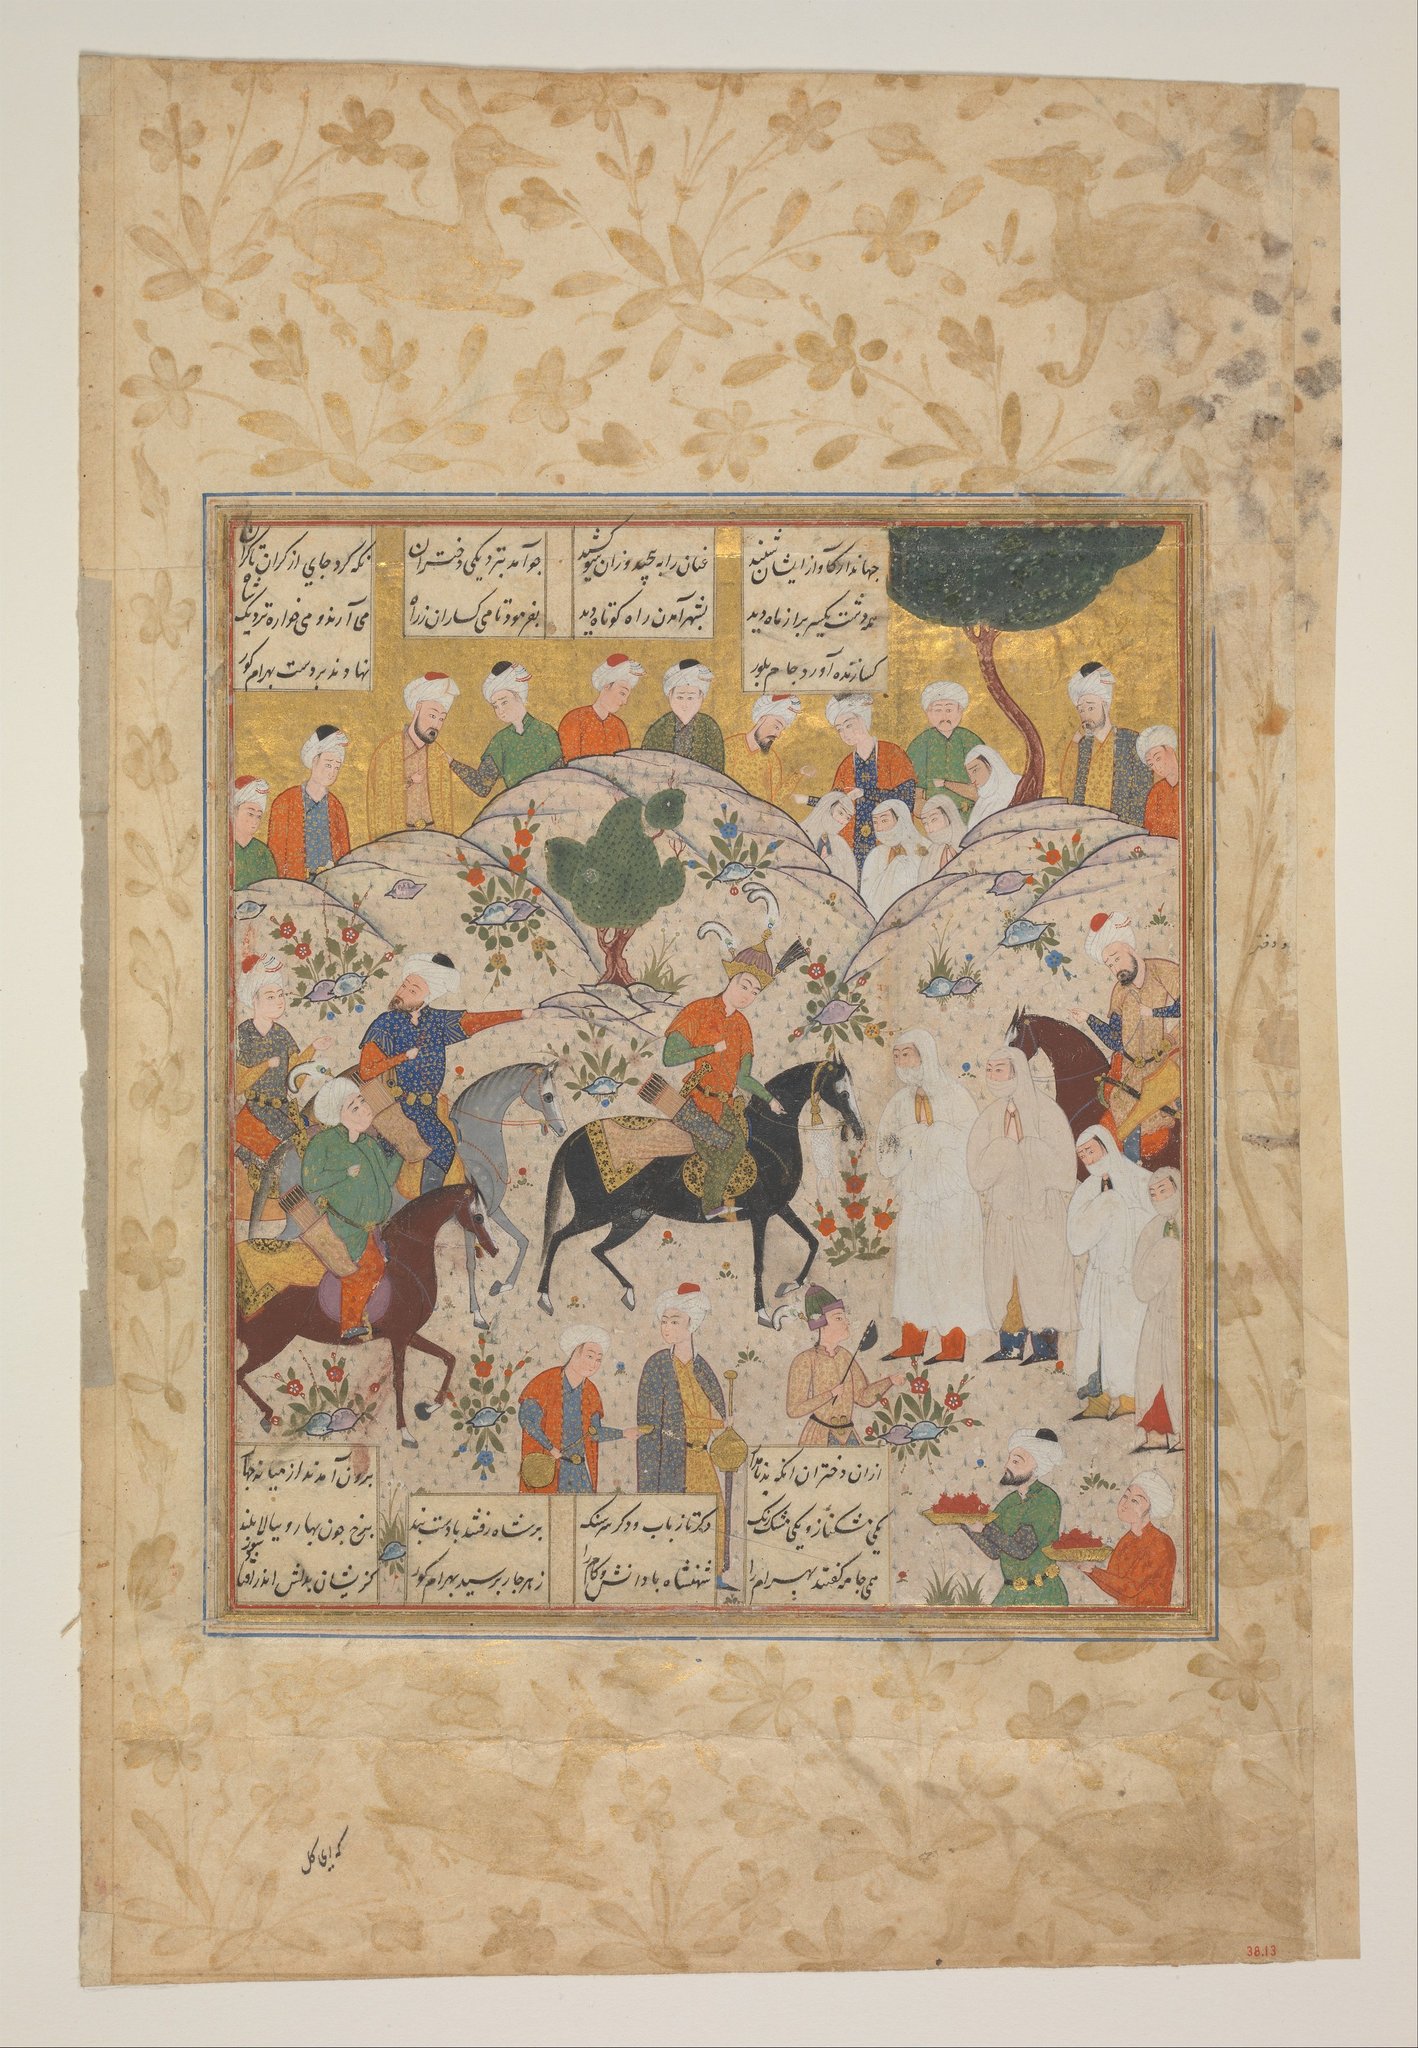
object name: folio from an illustrated manuscript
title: "Meeting of Bahram Gur with a Princess", Folio from a Shahnama (Book of Kings)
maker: abu'l qasim firdausi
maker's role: author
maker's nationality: iranian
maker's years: 935-1020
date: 1534-1566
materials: gold, ink, paper, watercolor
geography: iran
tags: human figures,poetry,horses